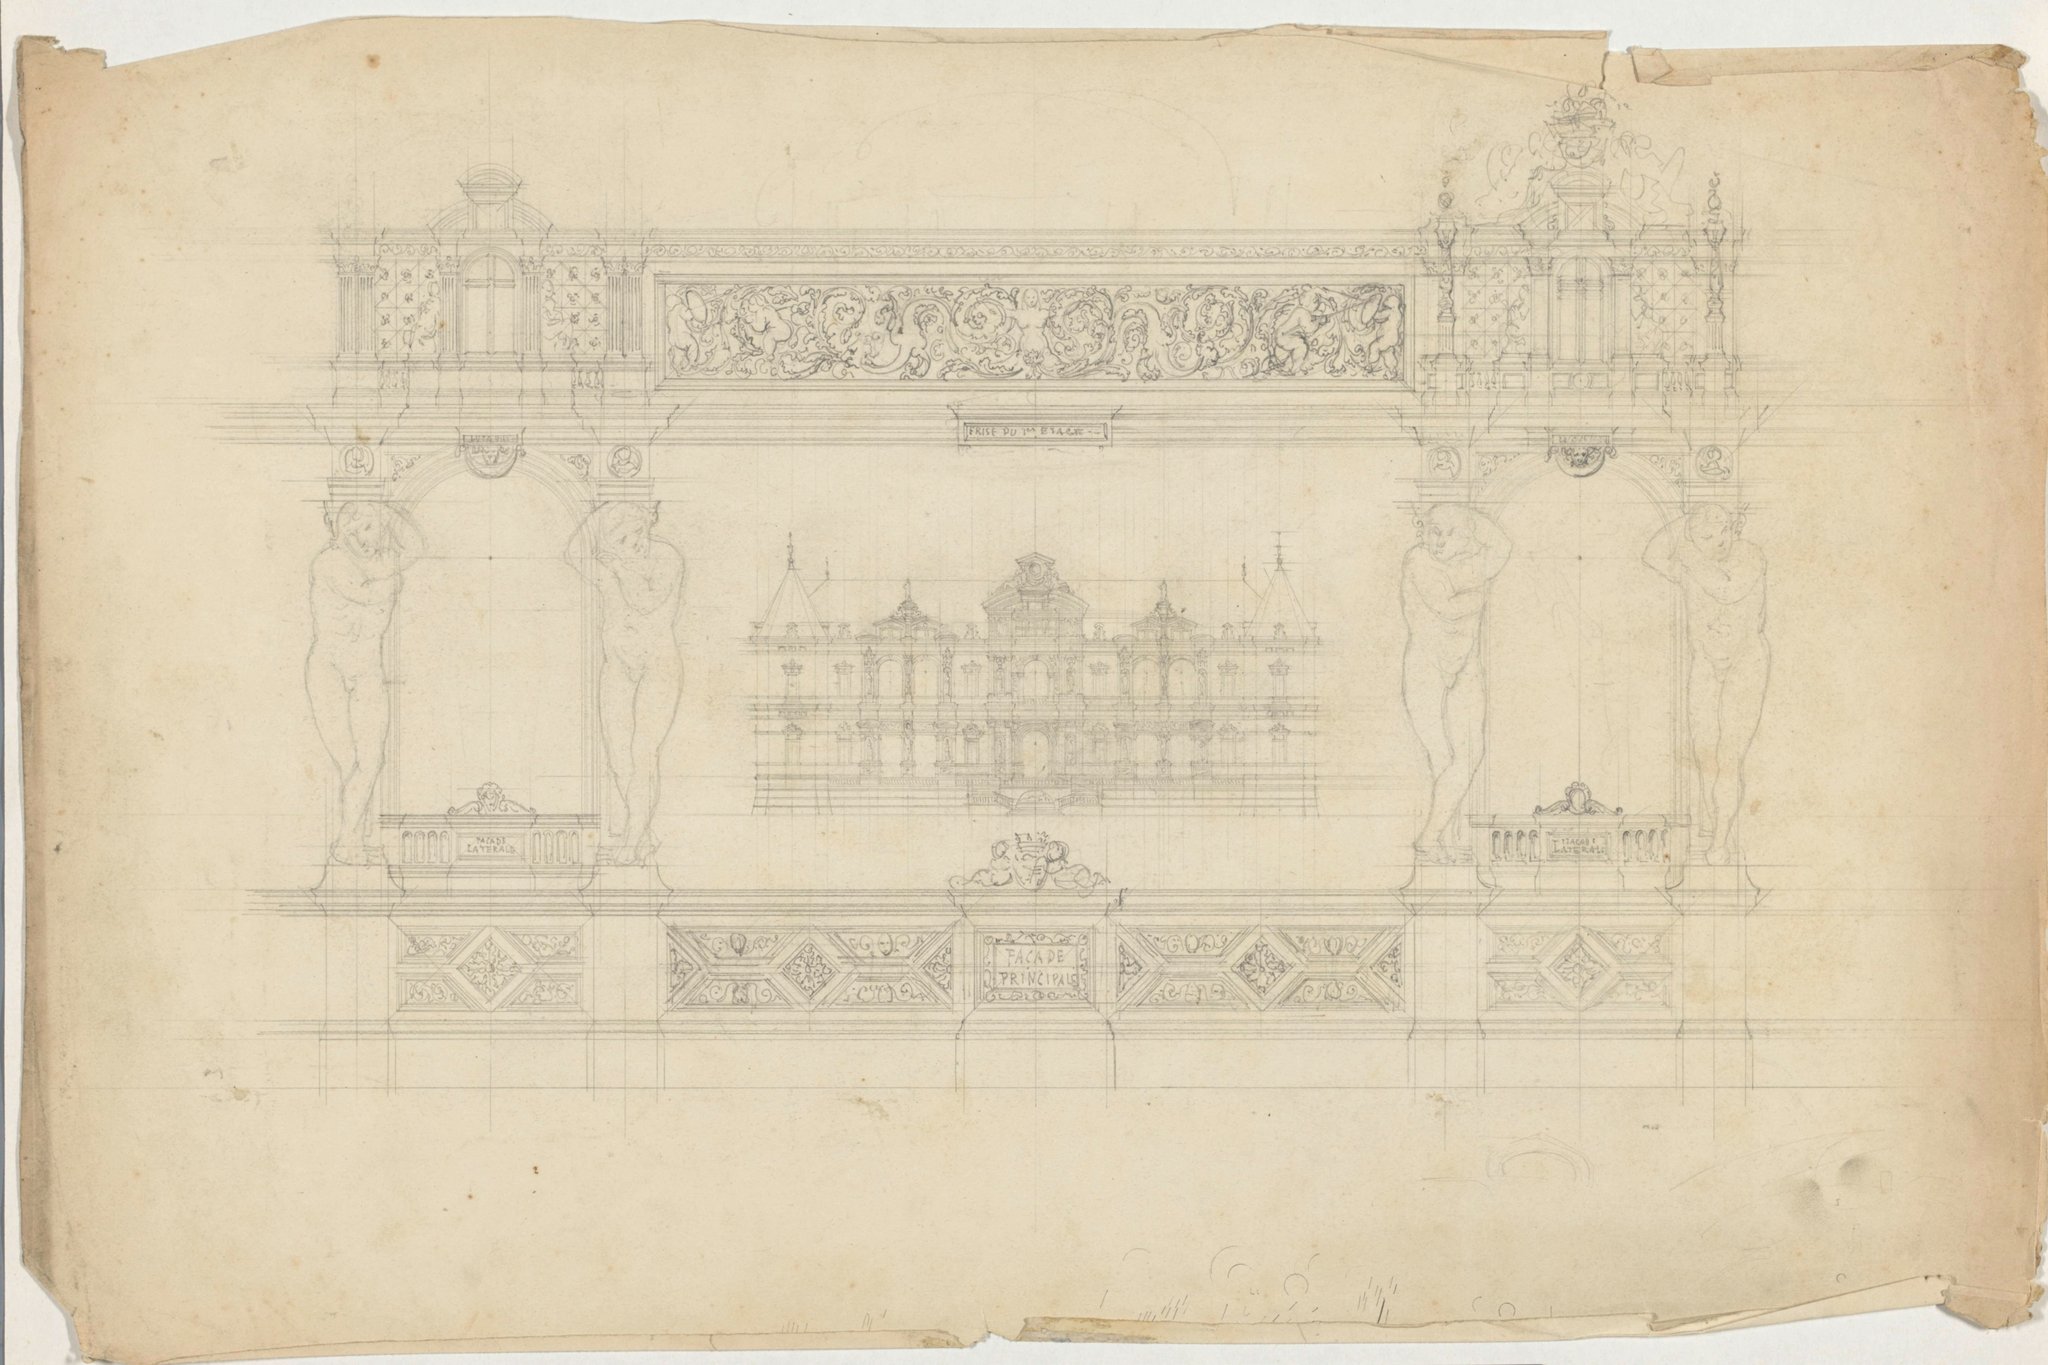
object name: design drawing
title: Façade van een gebouw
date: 1830-1850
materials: graphite, paper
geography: paris